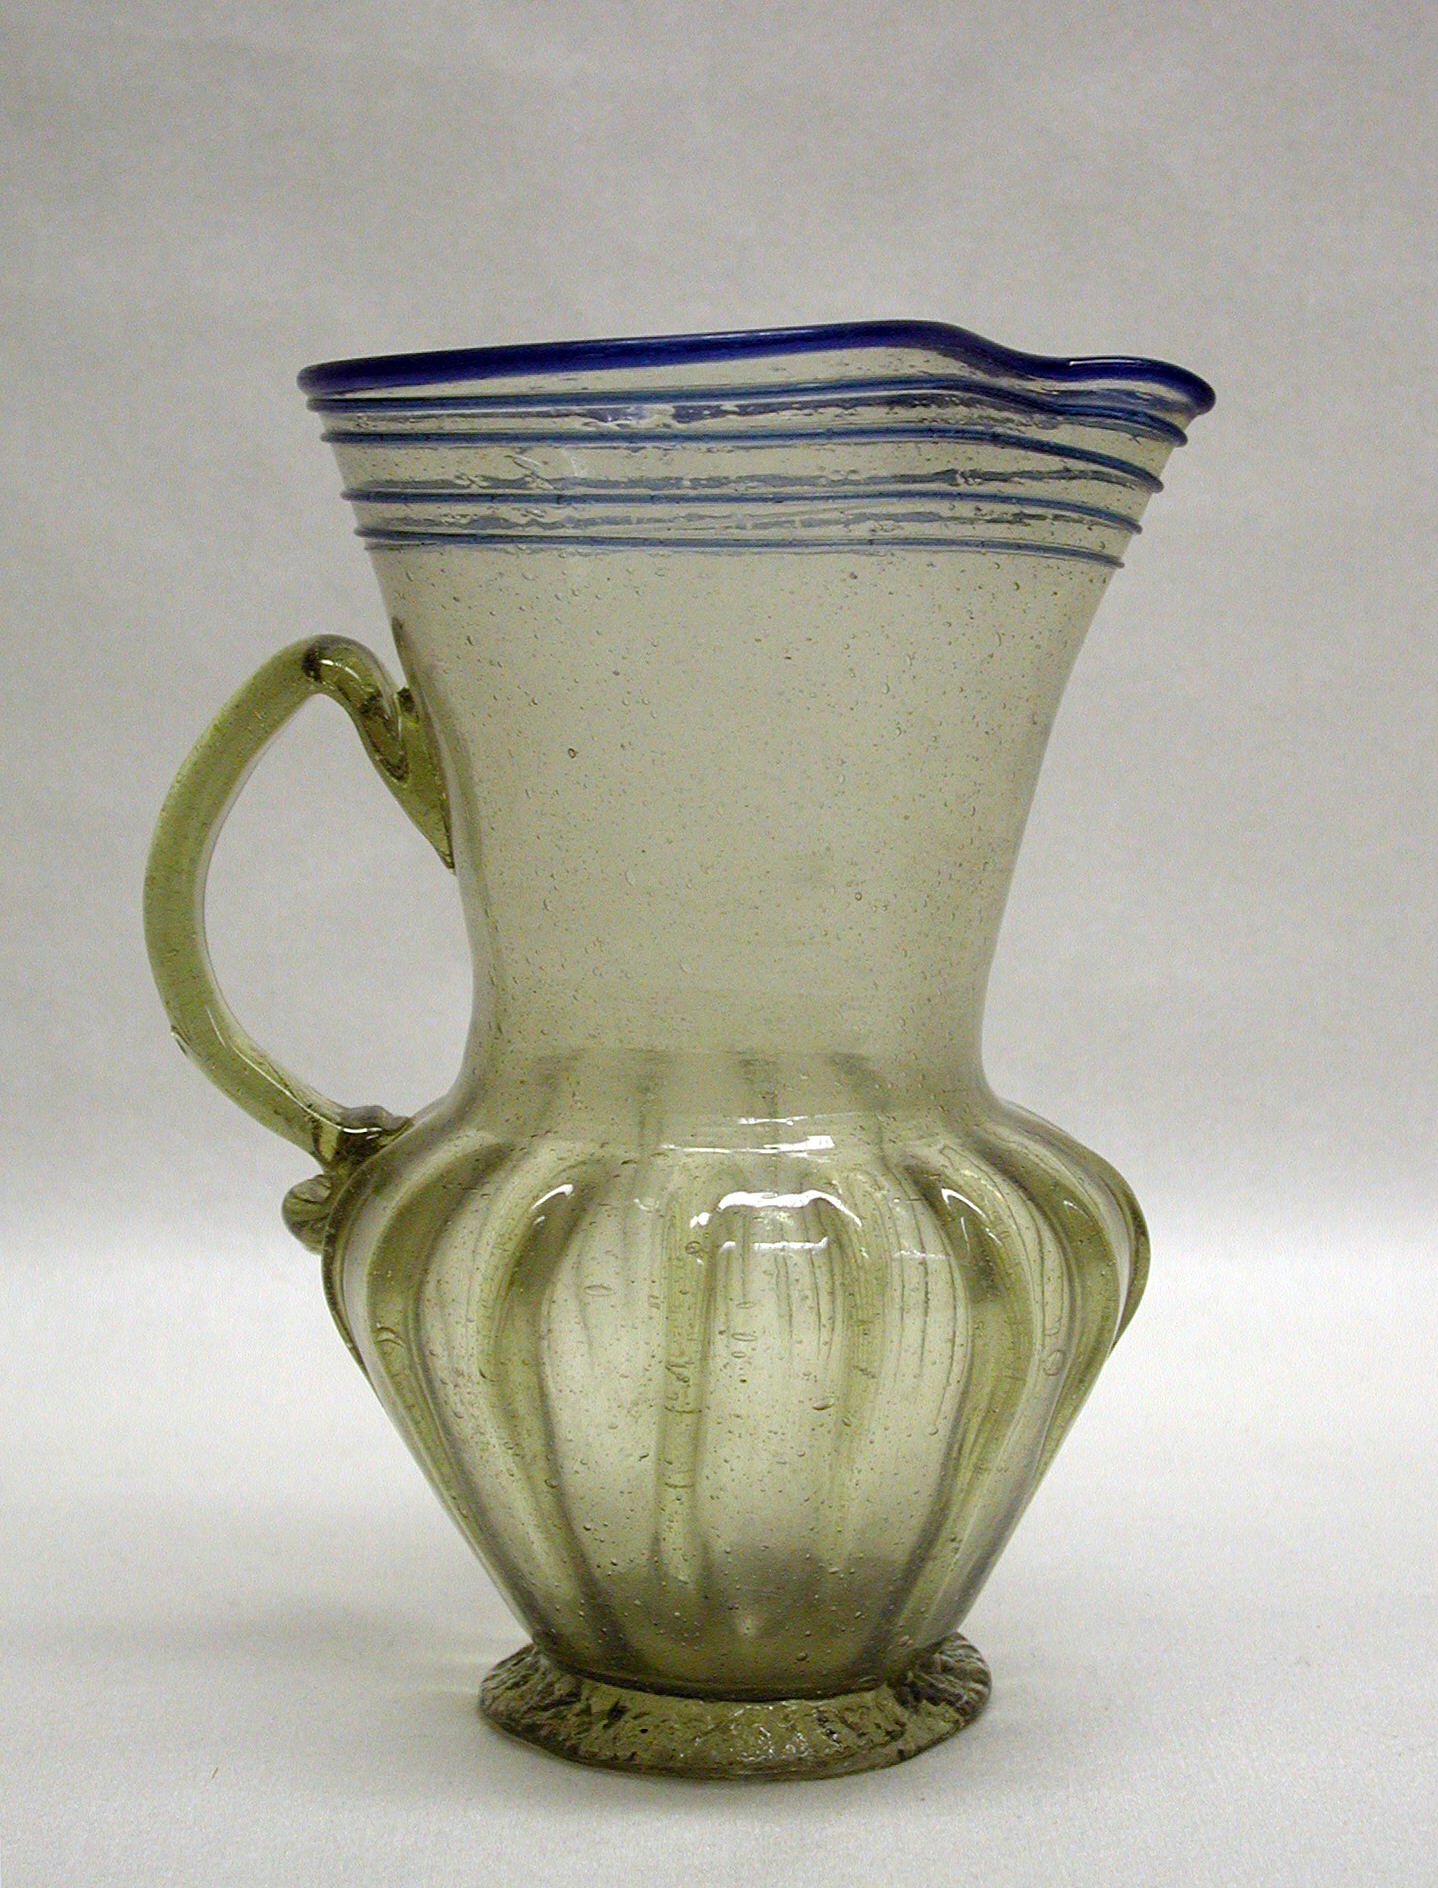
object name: jug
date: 1601-1700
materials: glass